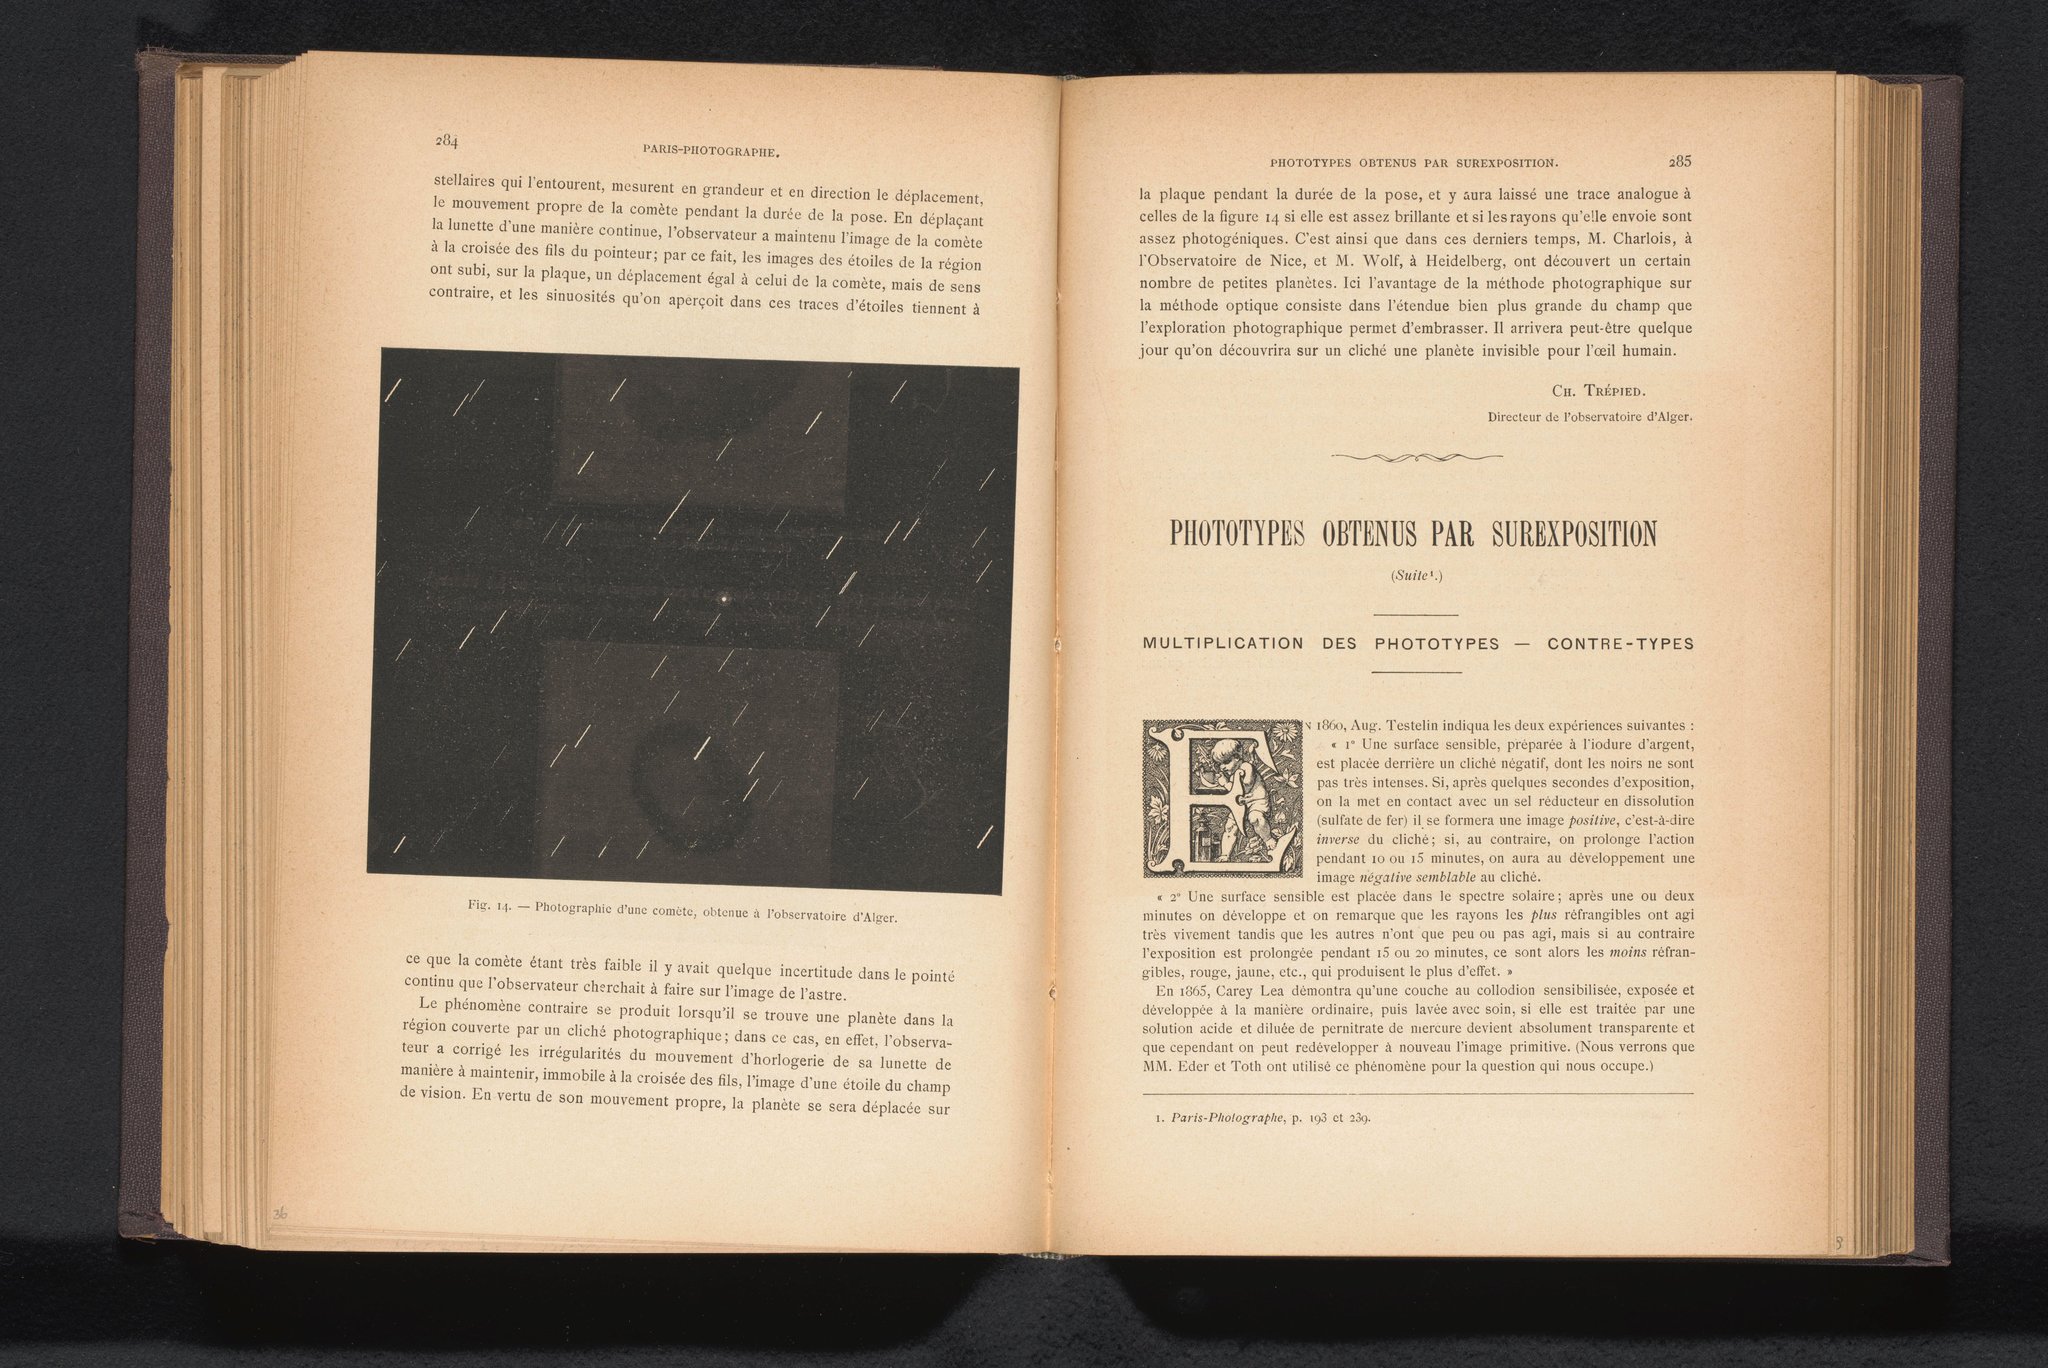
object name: page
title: Photographie d'une comète, obtenue à l'observatoire d'Alger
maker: Anonymous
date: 1883-1893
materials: paper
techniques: autotype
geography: algiers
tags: comet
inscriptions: number: ‘Fig. 14.’